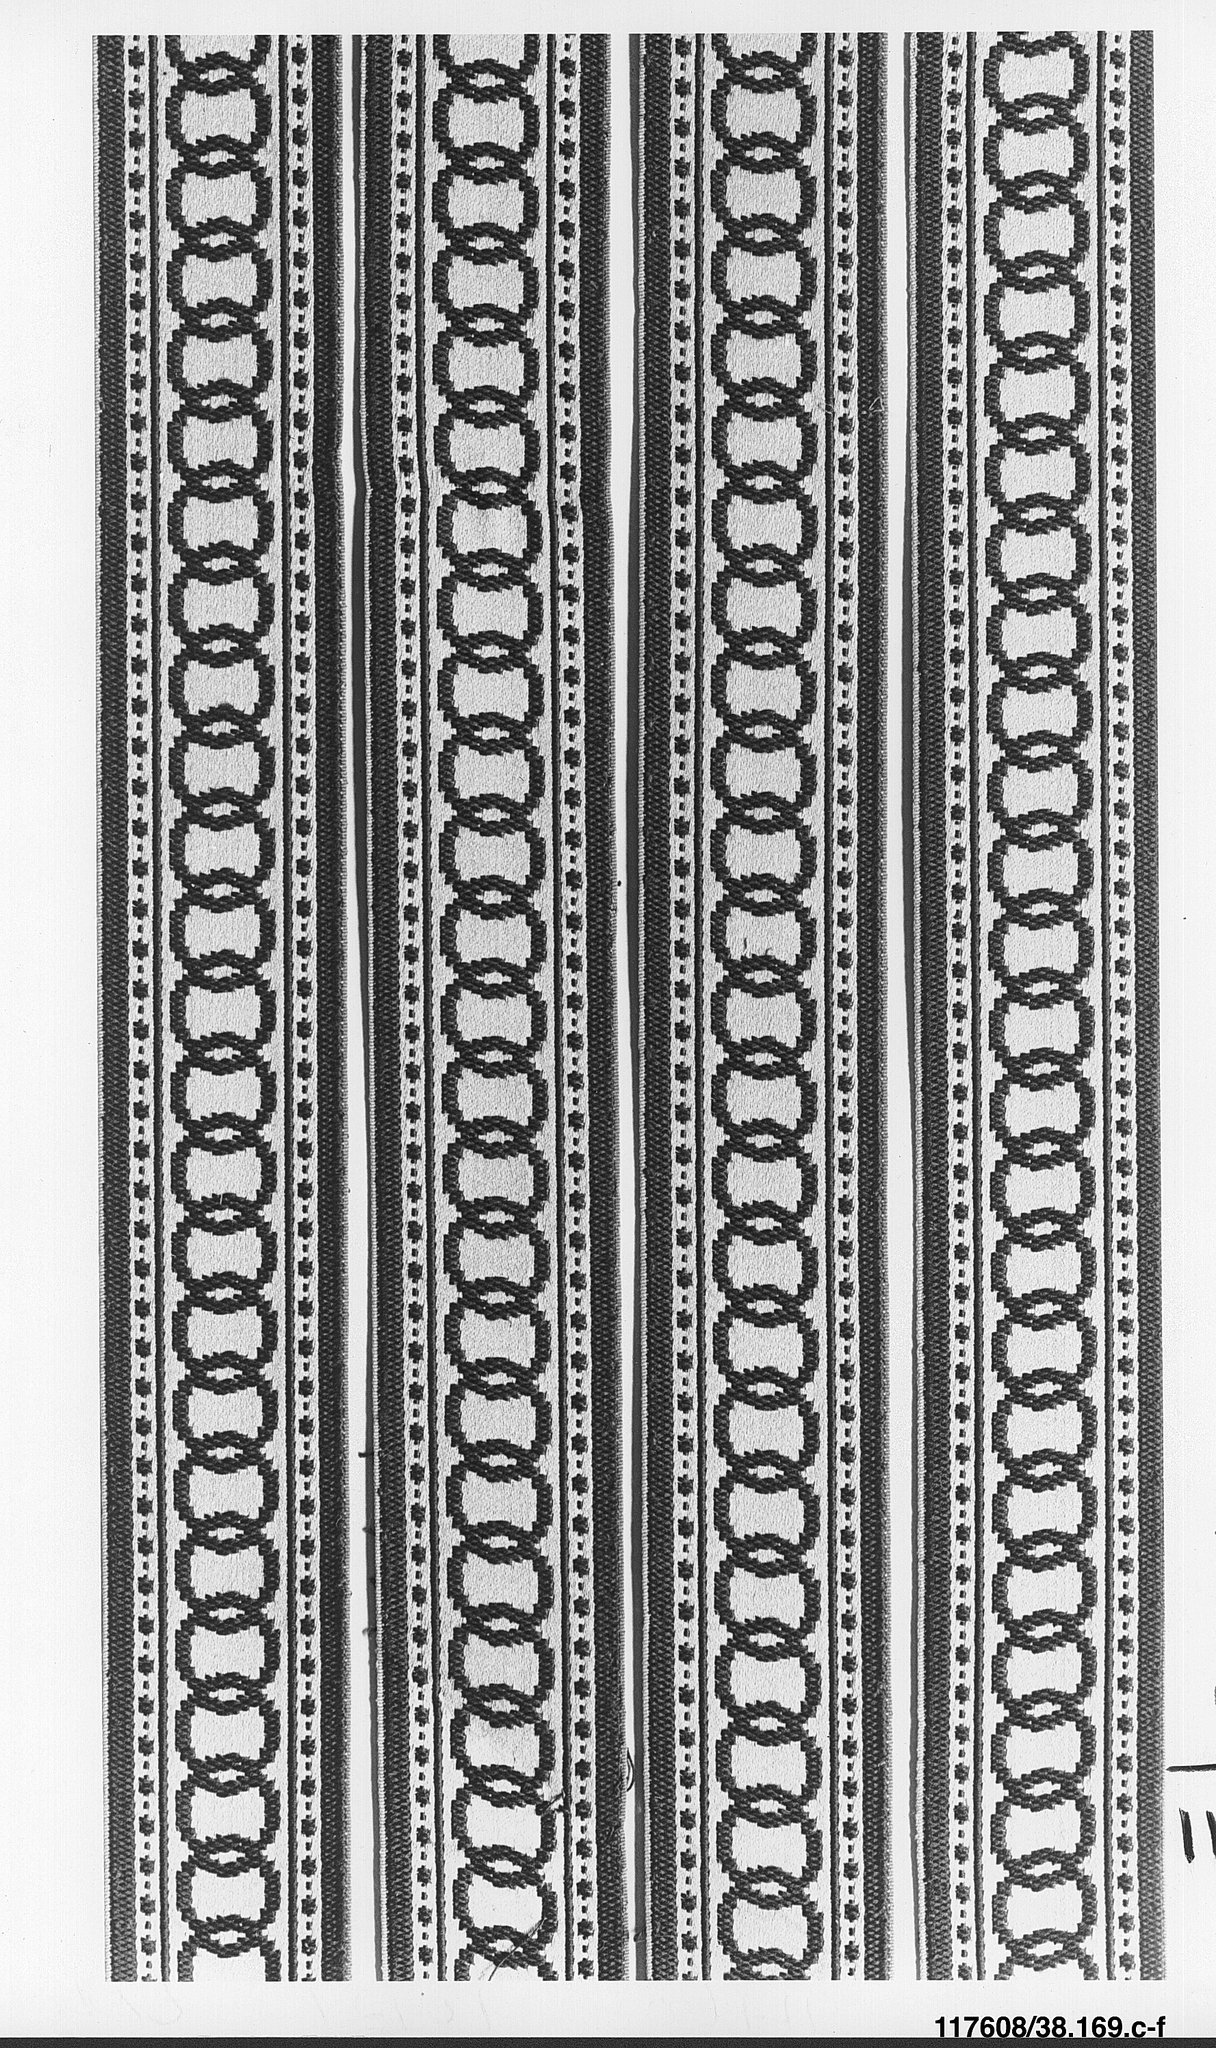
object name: upholstery panel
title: Part of a chair cover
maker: jean démosthène dugourc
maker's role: designer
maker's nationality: french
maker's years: 1749-1825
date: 1797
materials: silk